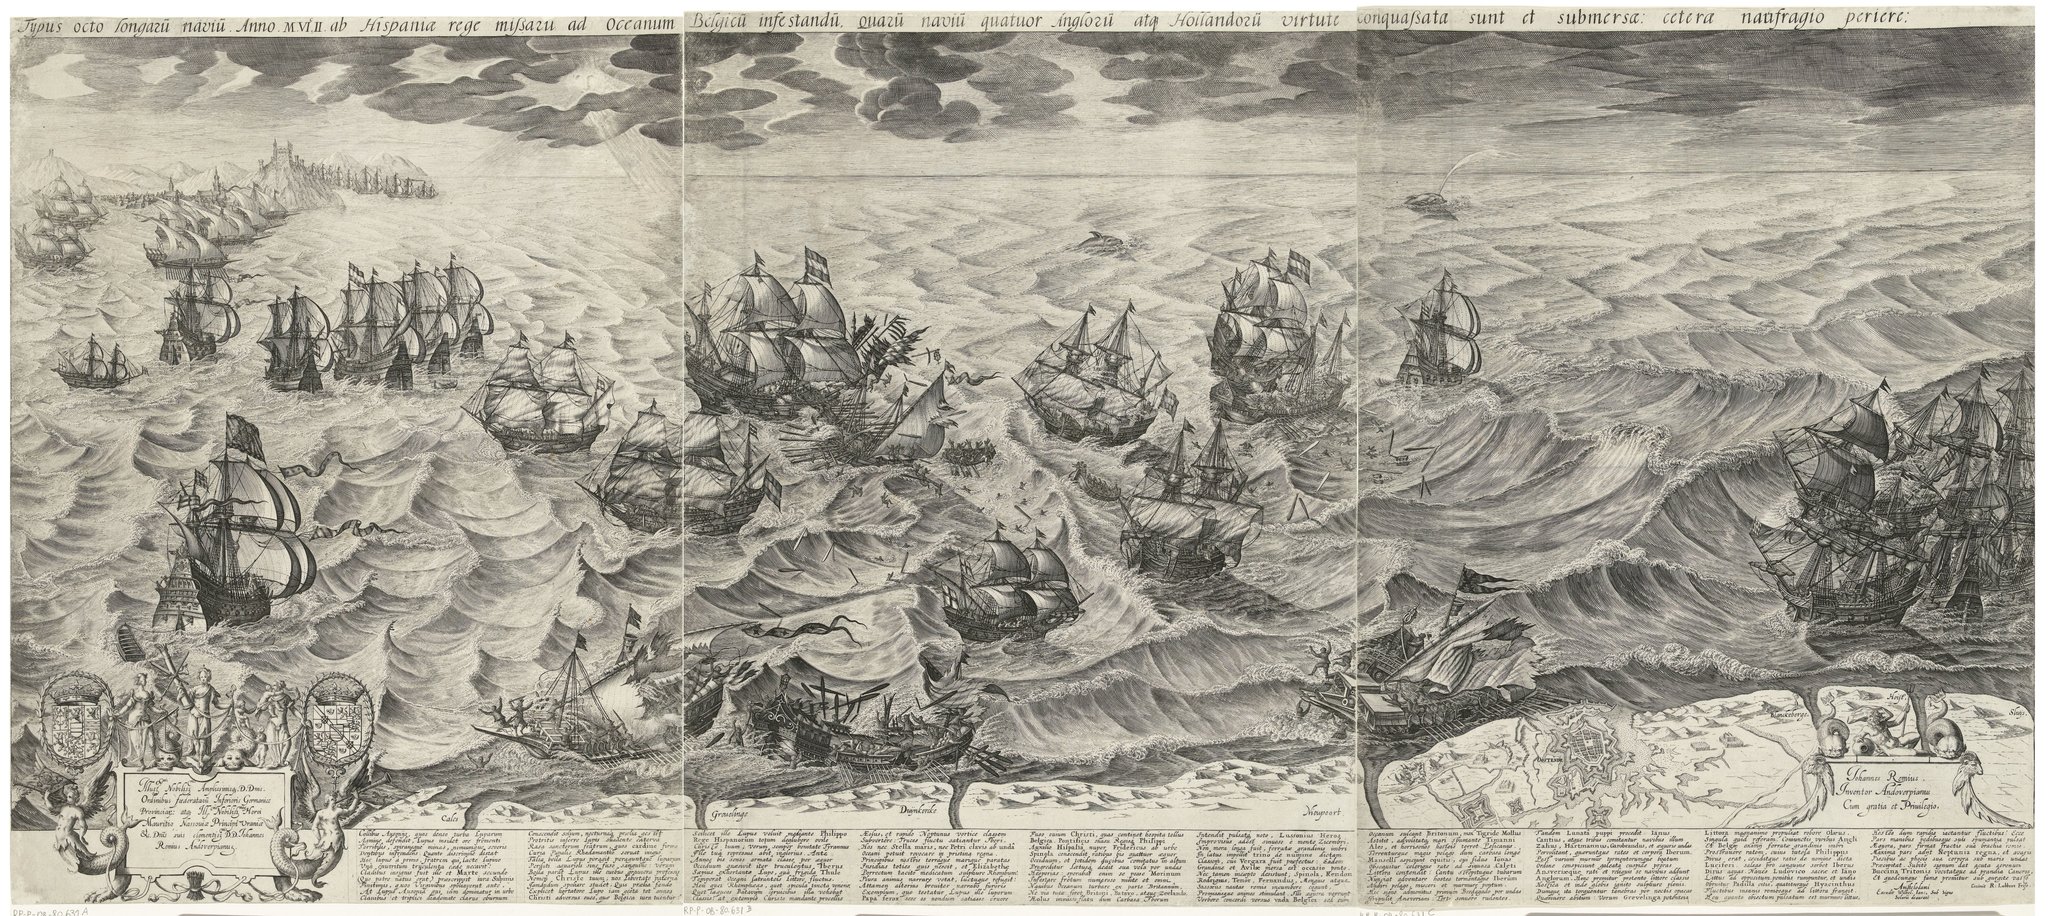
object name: print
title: Typus octo langaru[m] naviu[m] Anno MVIcII ab Hispaniae rege missaru[m] ad Oceanum Belgicu[m] infestandu[m], quaru[m] naviu[m] quator Angloru[m] atque Hollandoru[m] virtute conquassata sunt et submersae: ceterae naufragio periere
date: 1602-1603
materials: paper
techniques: engraving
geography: antwerp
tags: battle (+ naval force), english channel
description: De vernietiging van de Spaanse galeien in het Kanaal voor de Vlaamse kust door de Staatse vloot onder vice-admiraal Jacob van Duivenvoorde, heer van Obdam, 3 oktober 1602. Grote voorstelling, het geheel bestaande uit drie bladen. Onderan de Vlaamse kust van Calais to Sluis. Met onderschrift van 10 kolommen in het Latijn.